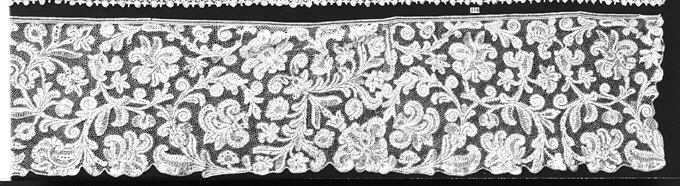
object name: fragment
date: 1701-1800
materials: lace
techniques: lace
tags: flowers,leaves